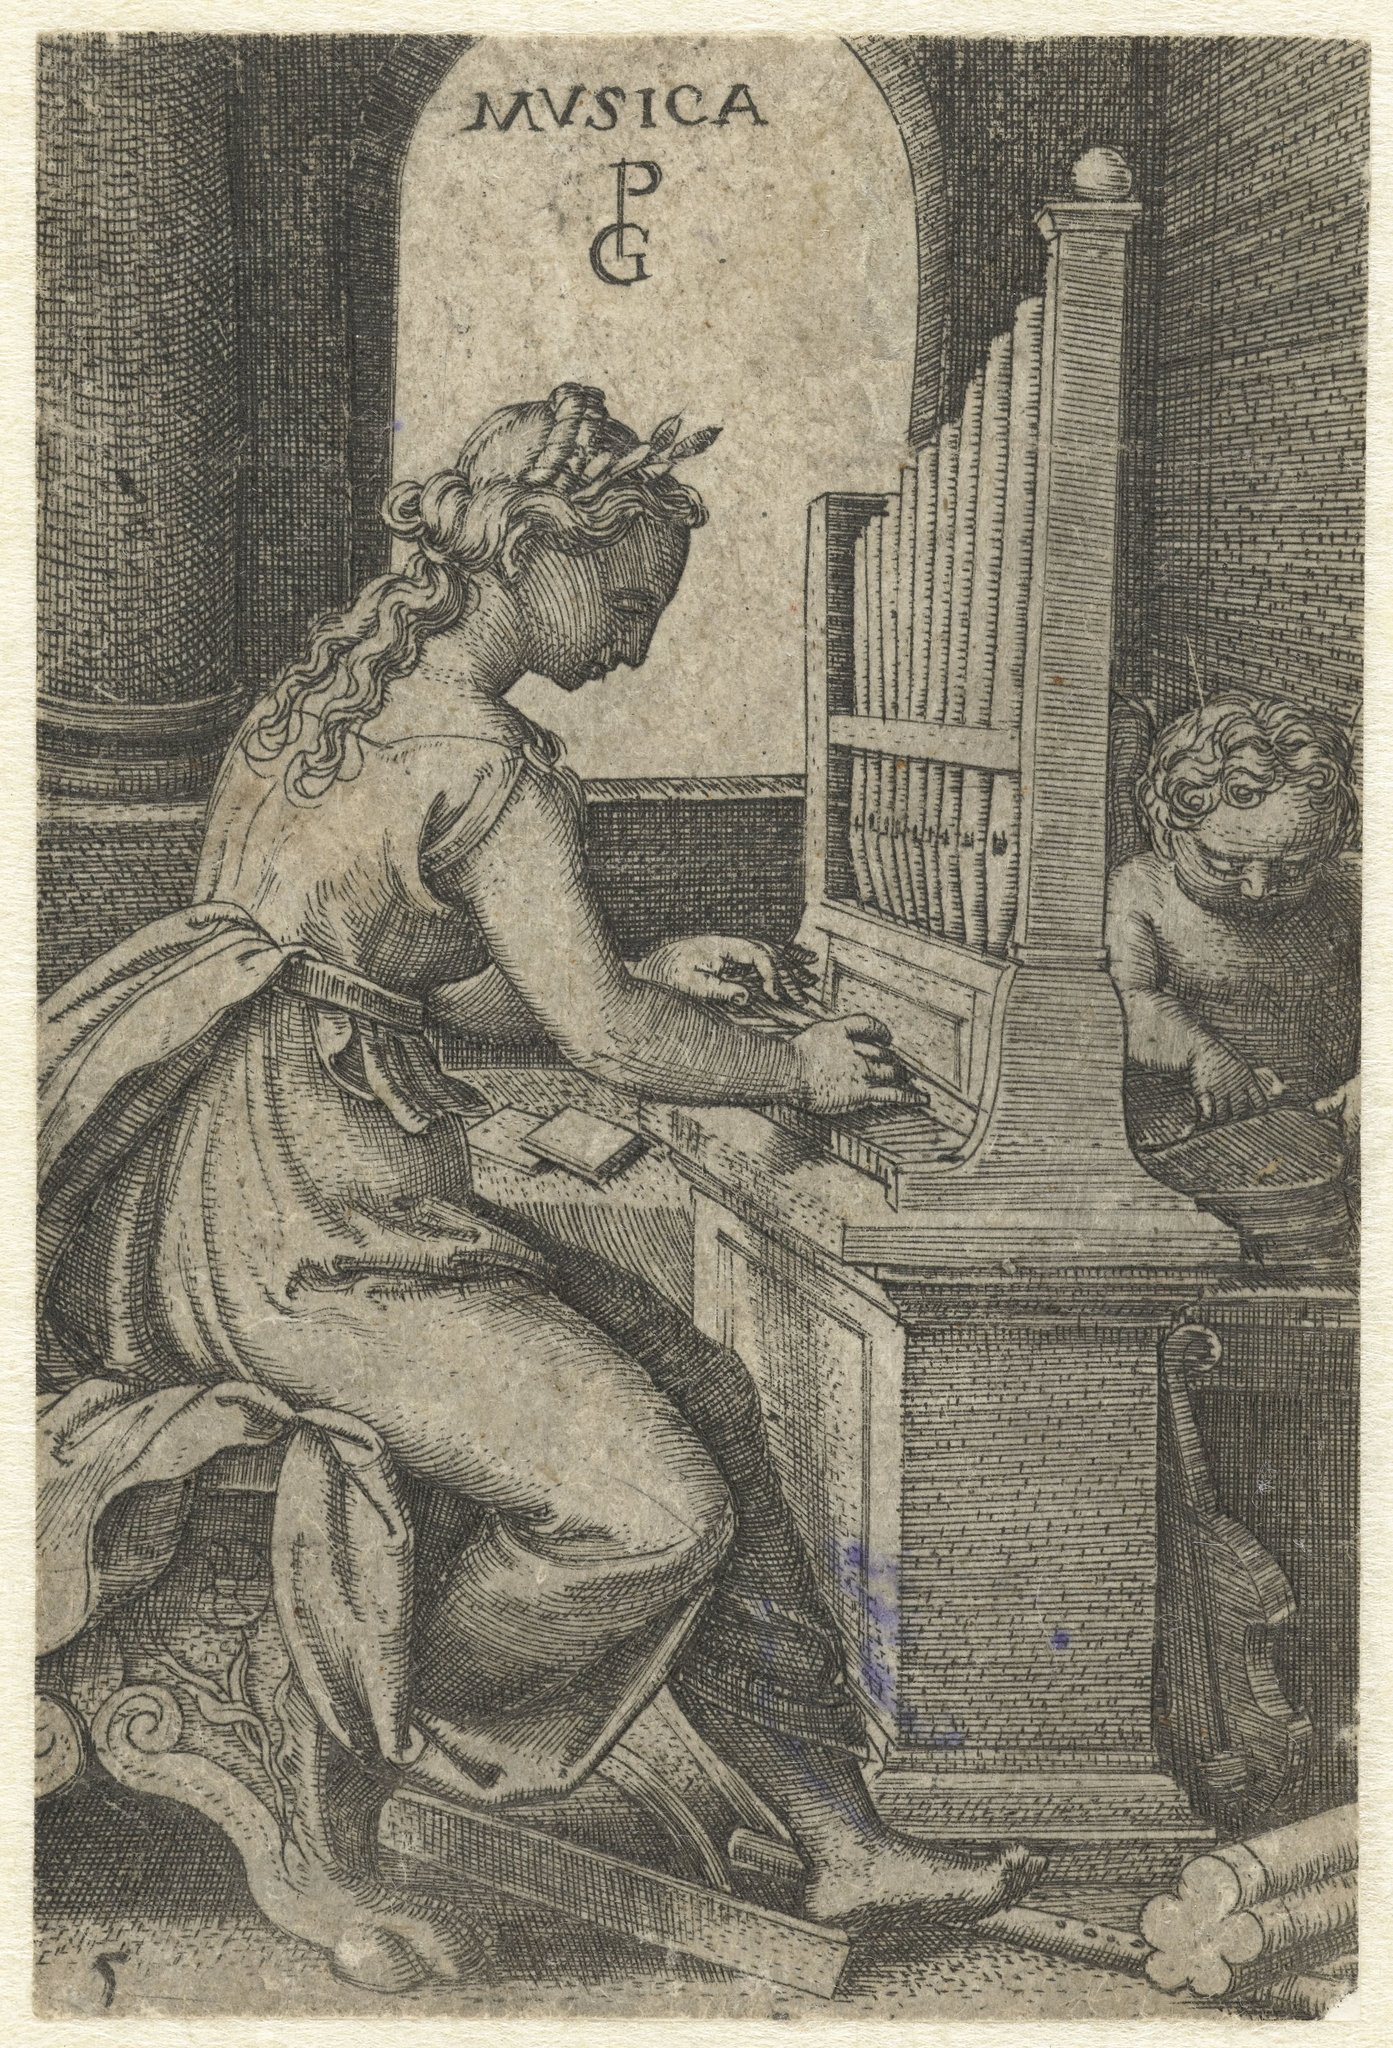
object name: print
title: Musica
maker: georg pencz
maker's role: draughtsman, painter, print maker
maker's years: 1500-1550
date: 1539-1543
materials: paper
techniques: engraving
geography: germany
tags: 'musica' (~ quadrivium); 'musica' (ripa), organ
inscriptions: collector's mark: Lugt 11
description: Vrouw als personificatie van Muziek (Musica), zij speelt op een orgel waarvan de blaasbalg aan de achterkant wordt bediend door een putto. Op de grond liggen instrumenten zoals een fluit en een harp.